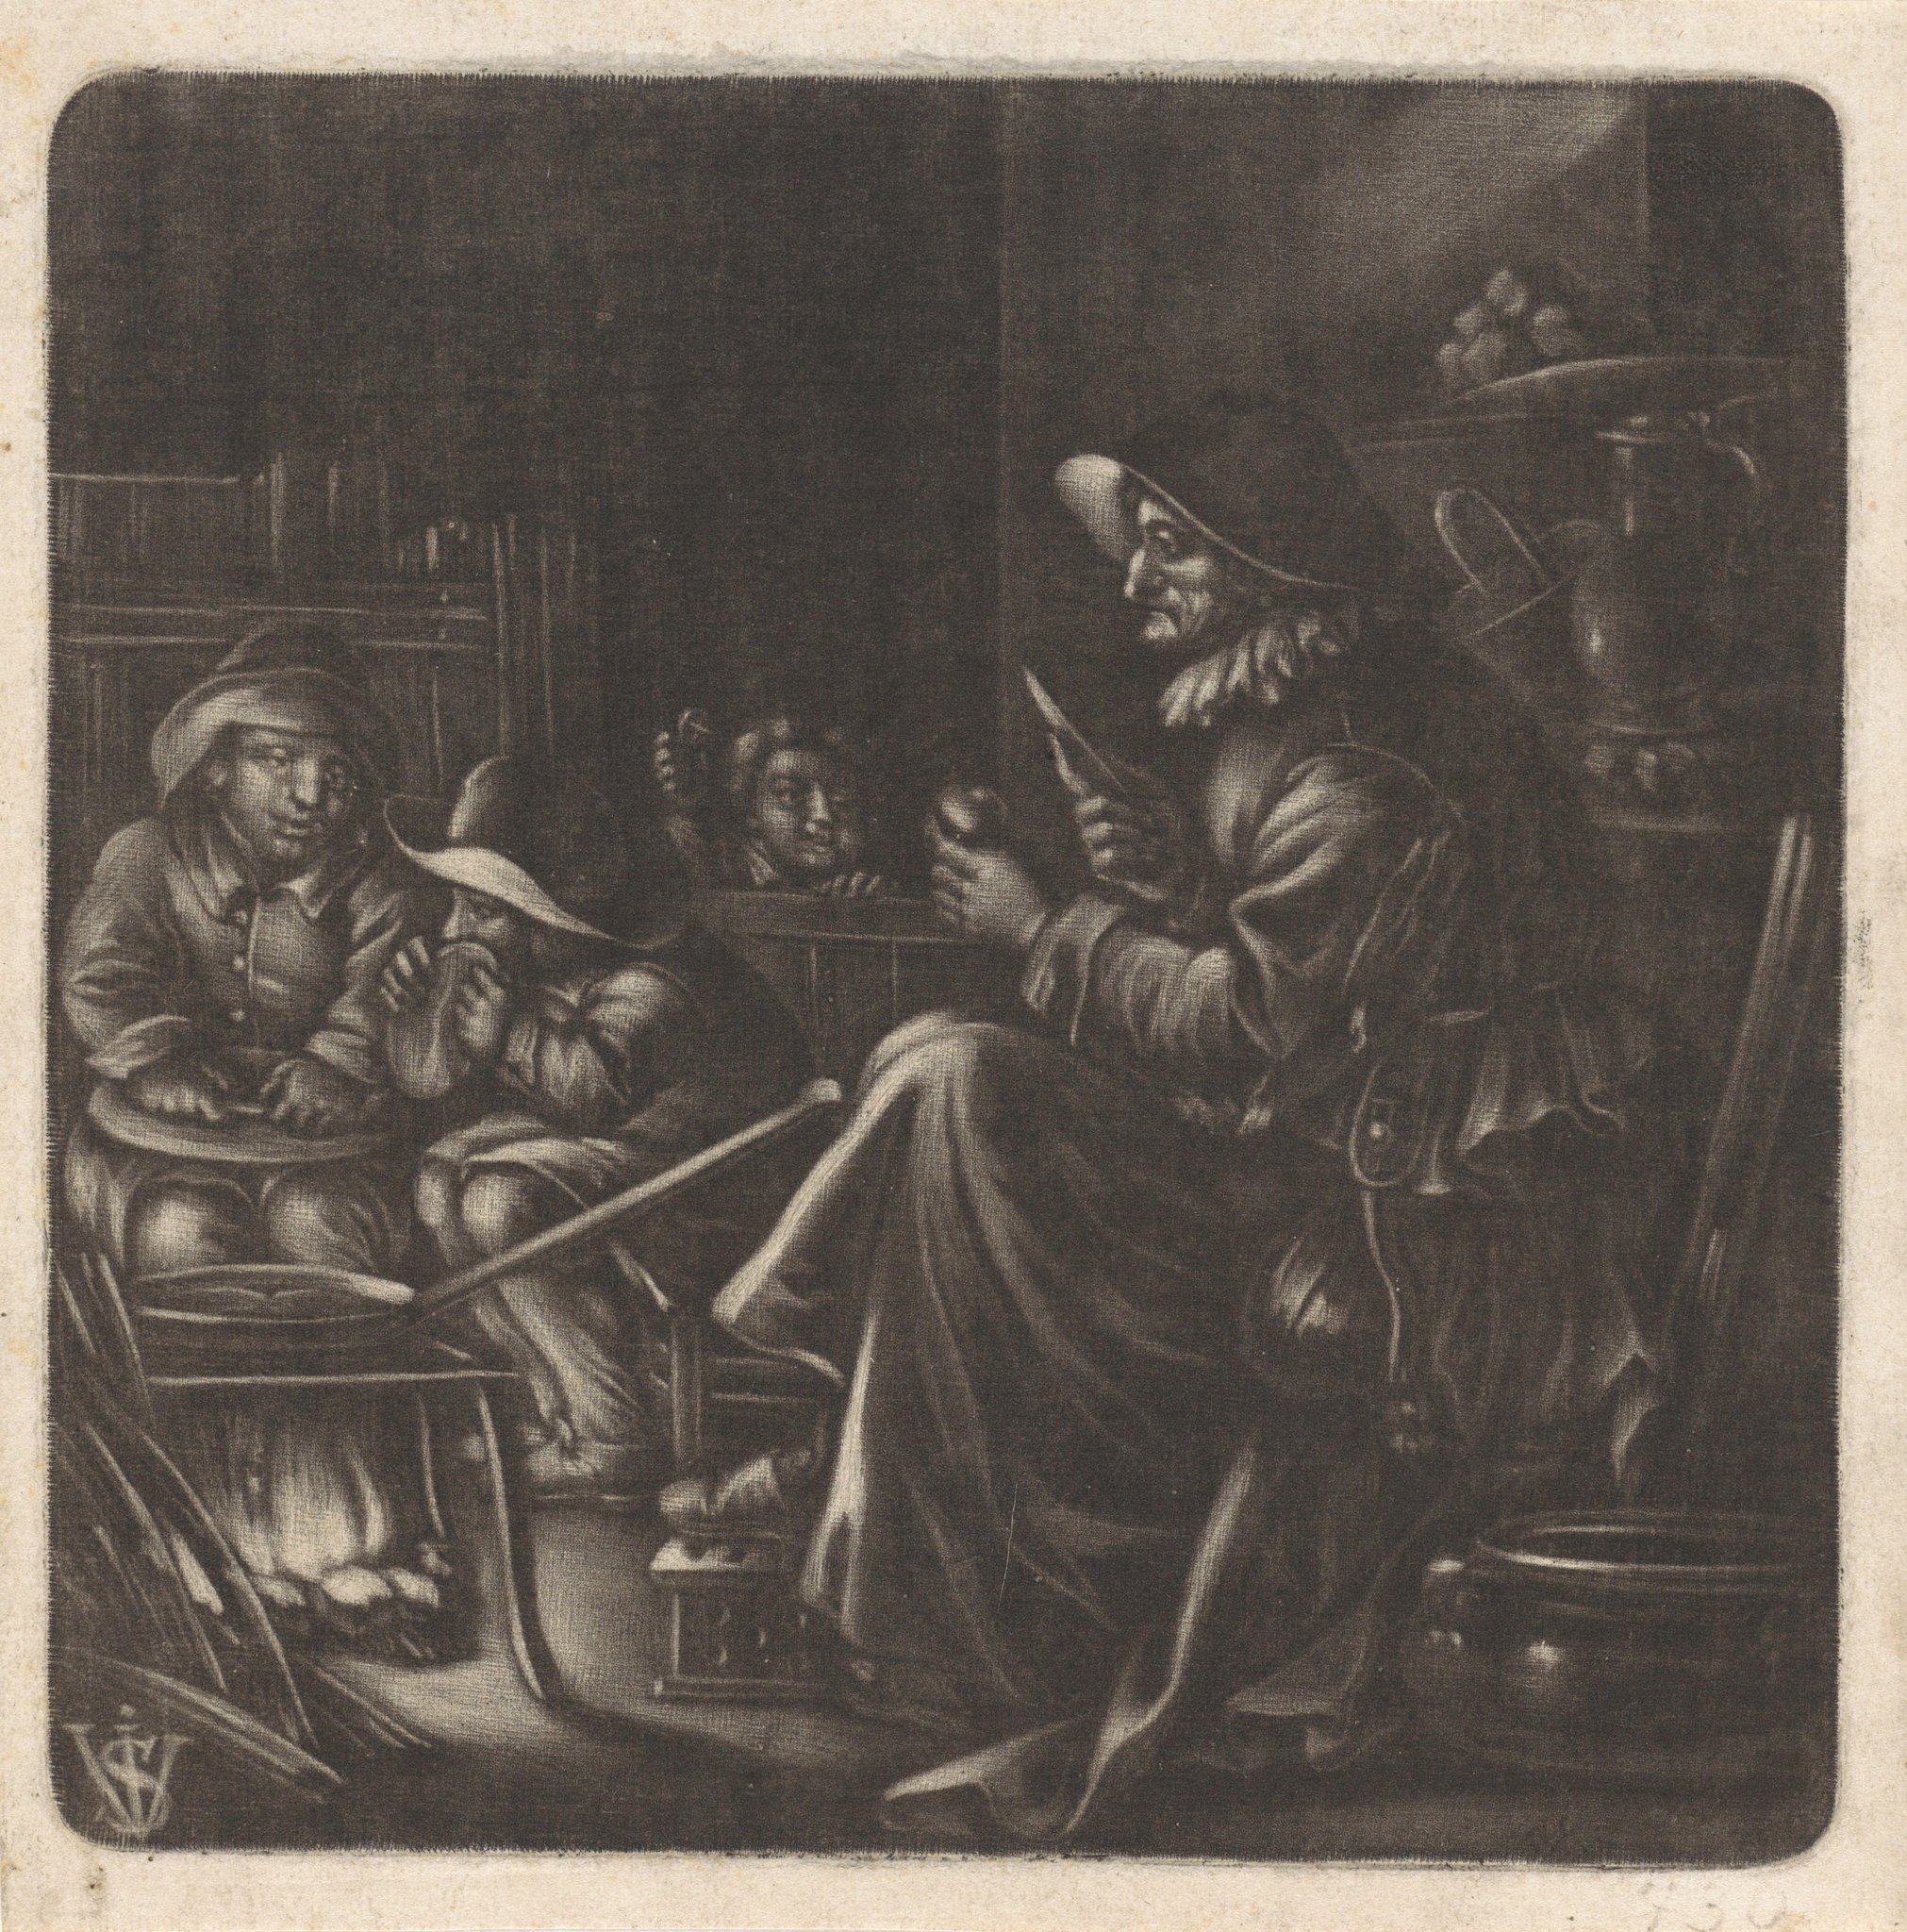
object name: print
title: Pannenkoekenbakster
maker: jan van somer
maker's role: draughtsman, print maker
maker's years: 1645-1699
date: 1655-1700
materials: paper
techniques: mezzotint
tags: pancakes, foot-stove, kitchen-interior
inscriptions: collector's mark: Lugt 2228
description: In een keuken zit een vrouw voor een vuur pannenkoeken te bakken, haar voet rust op een stoofje. Naast haar zitten twee kinderen pannenkoeken te eten. Op de achtergrond een derde kind met een tol.